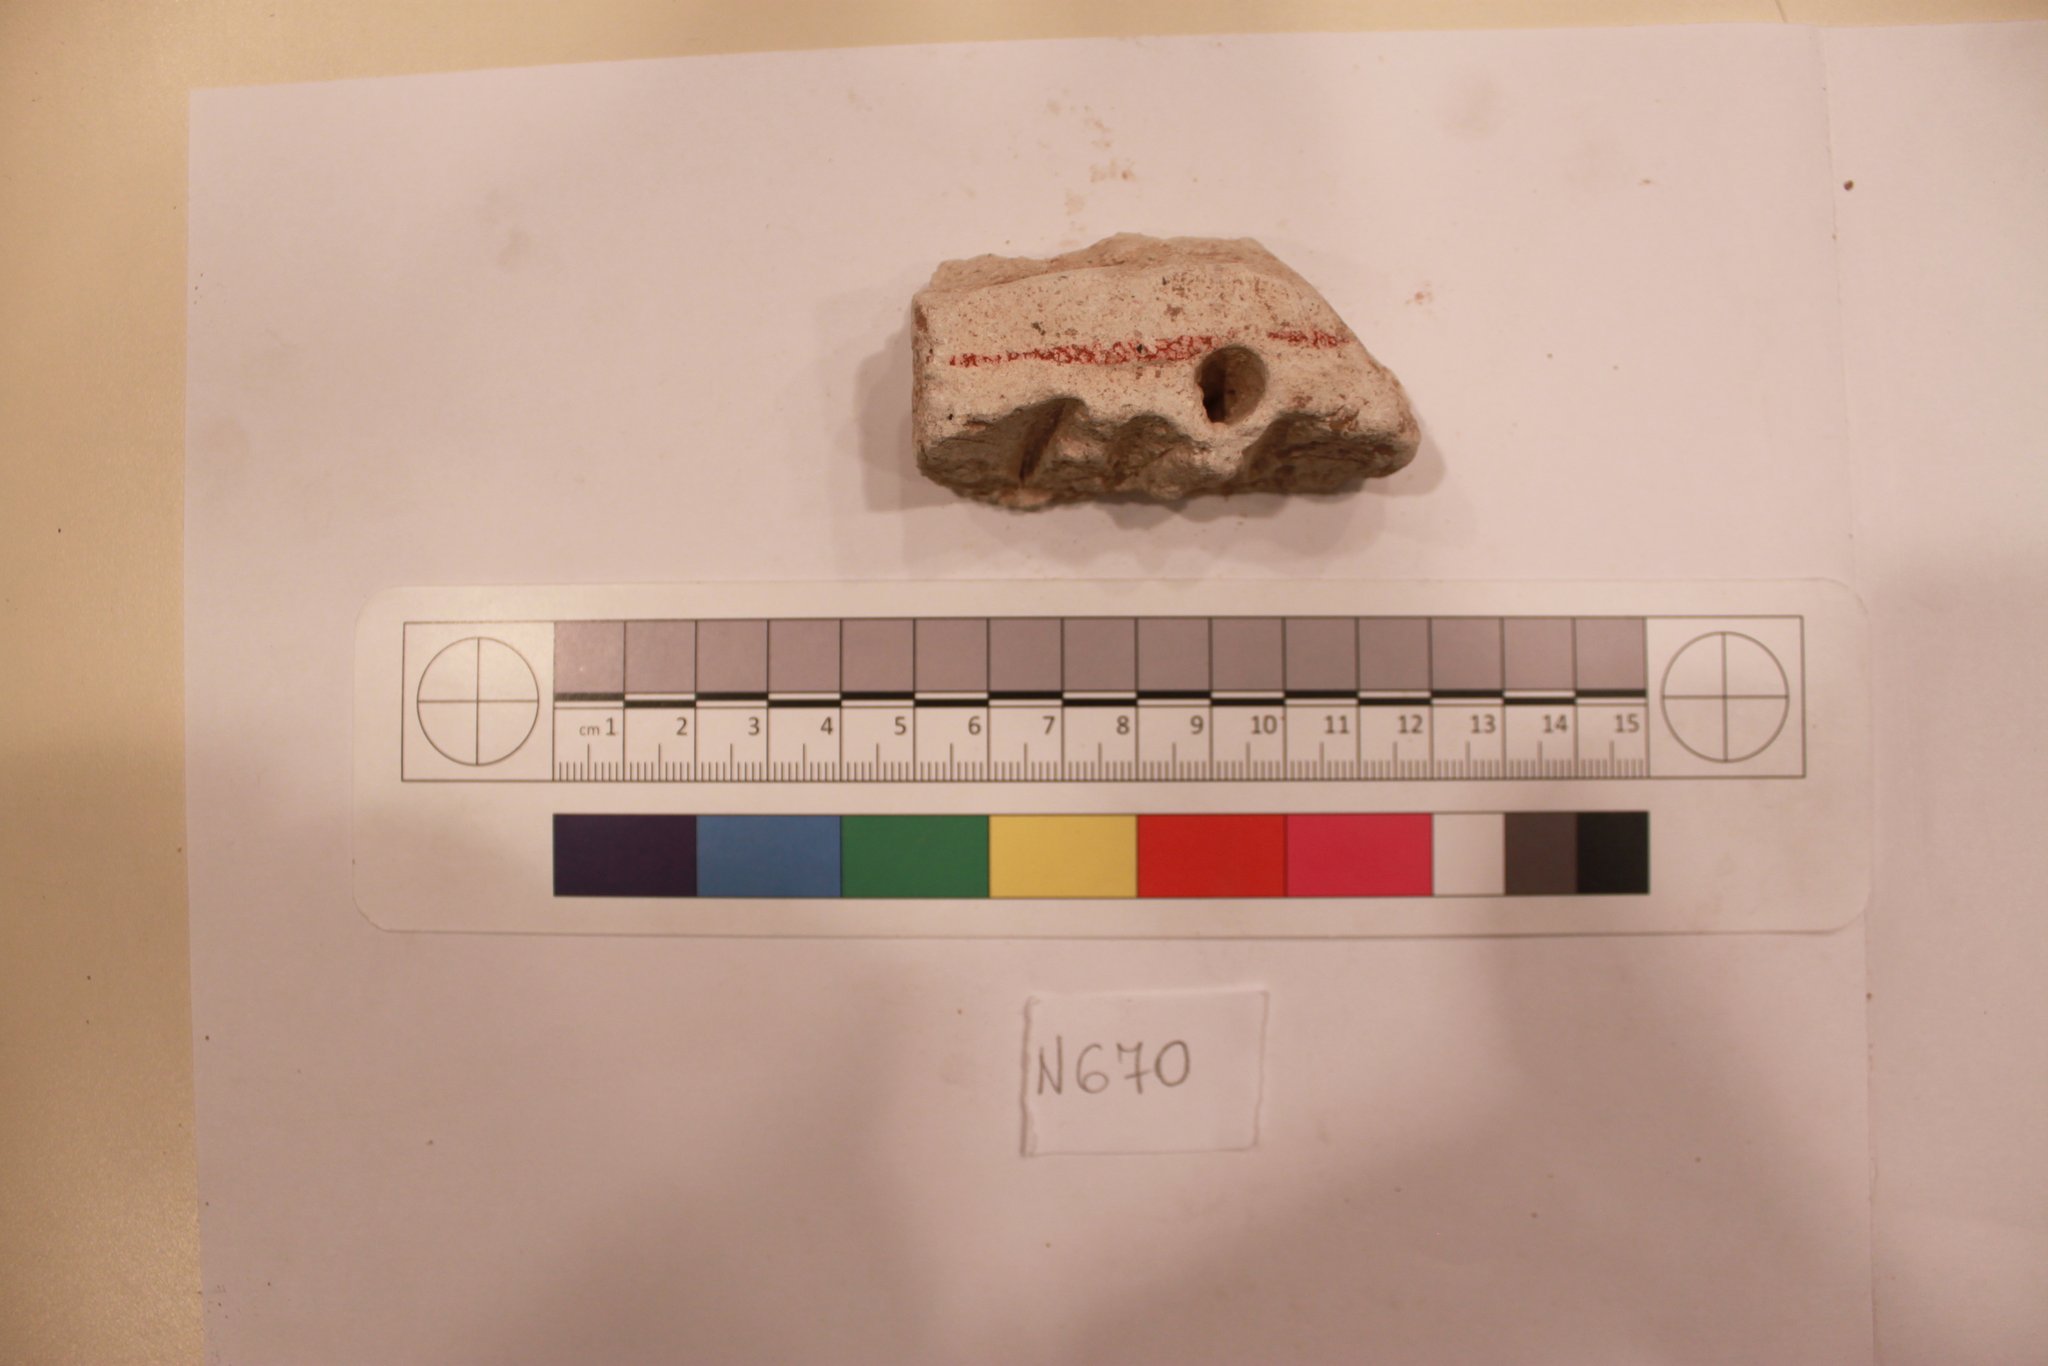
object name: fragment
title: Stucco Fragment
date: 701-1200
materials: plaster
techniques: carving, painting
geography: iran